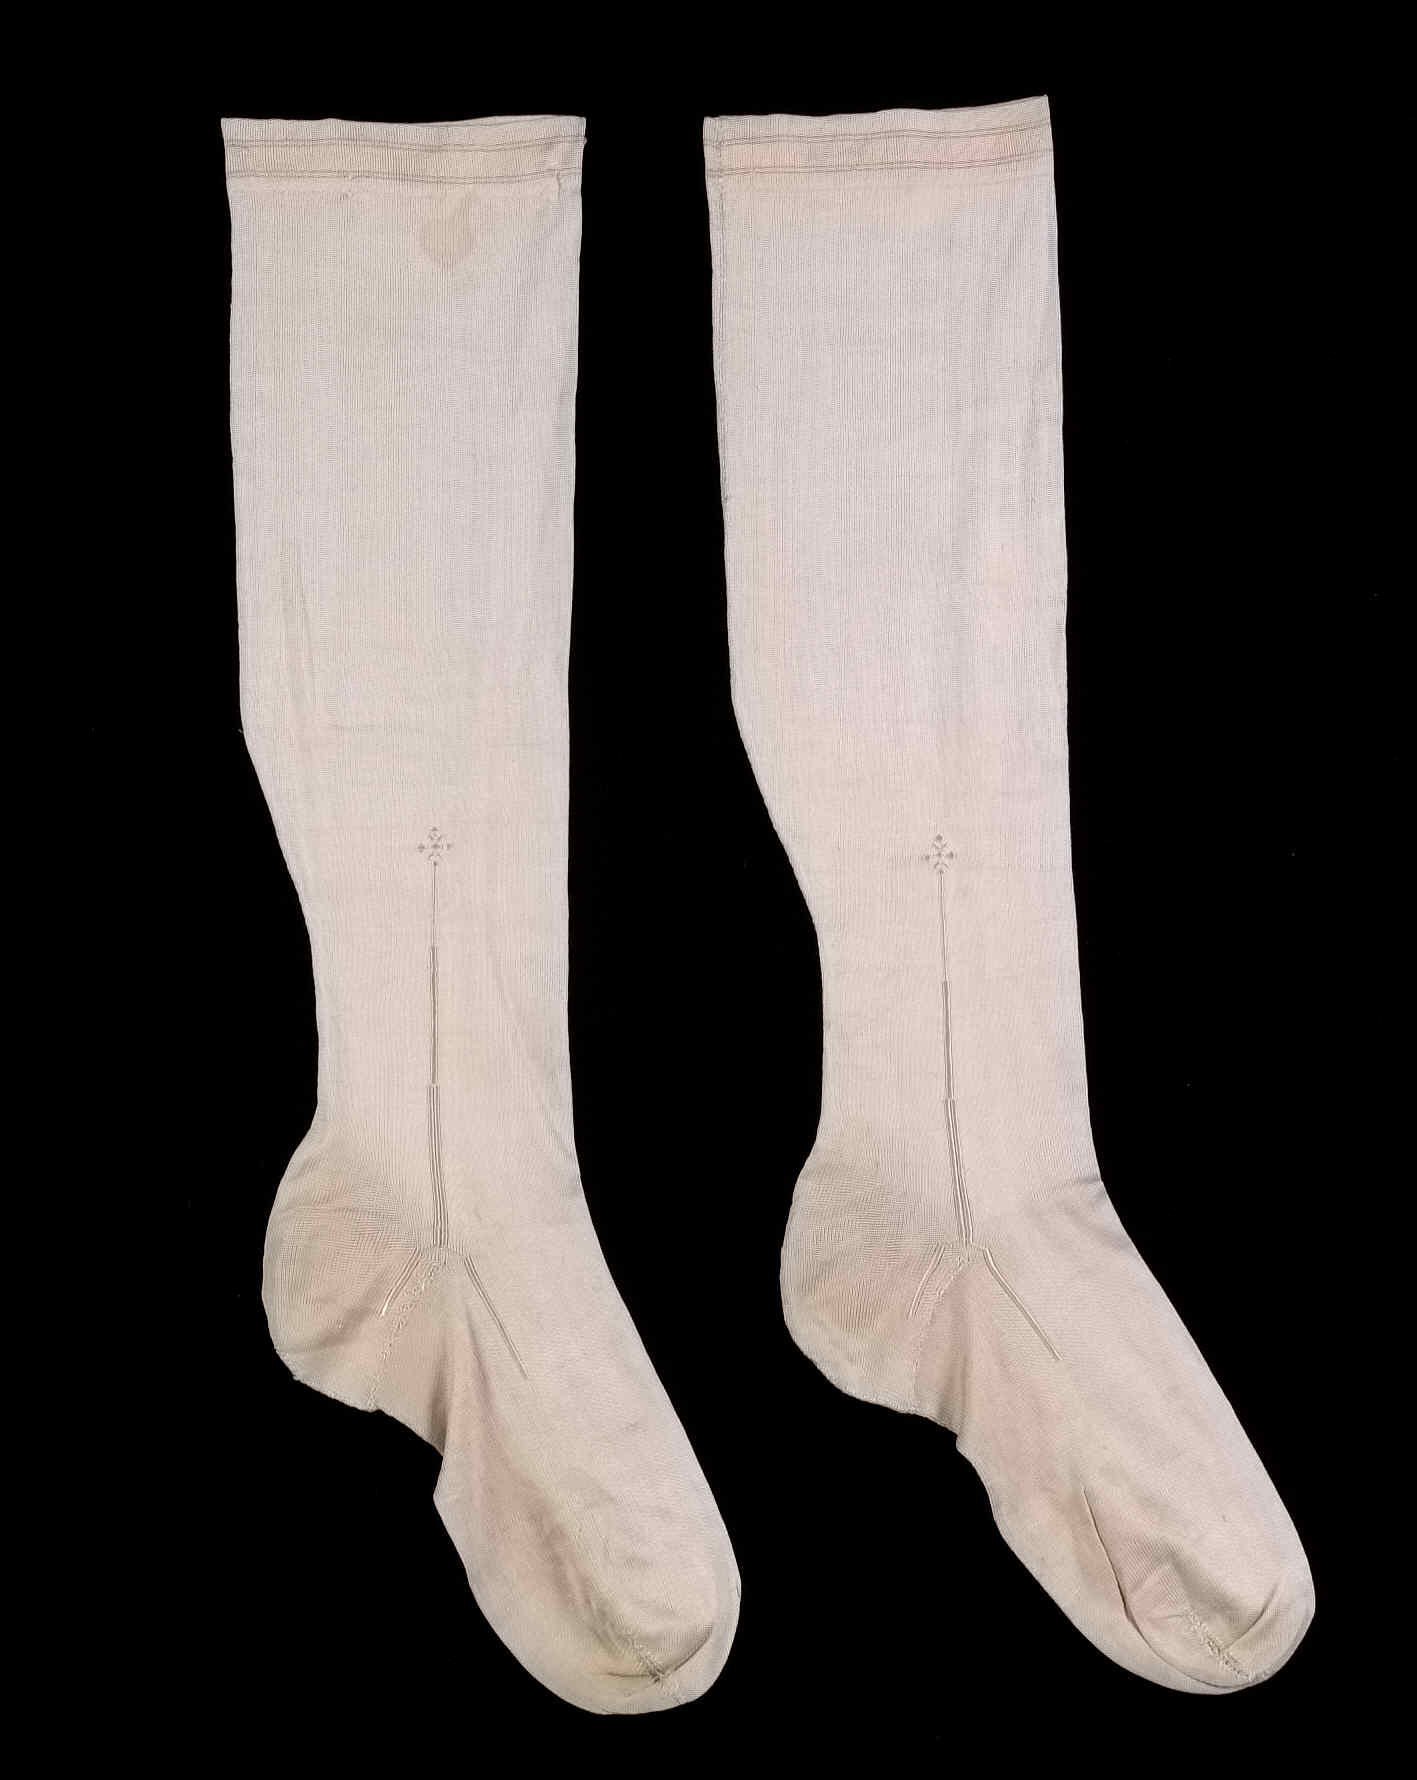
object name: wedding stocking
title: Wedding stockings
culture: american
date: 1843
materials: silk